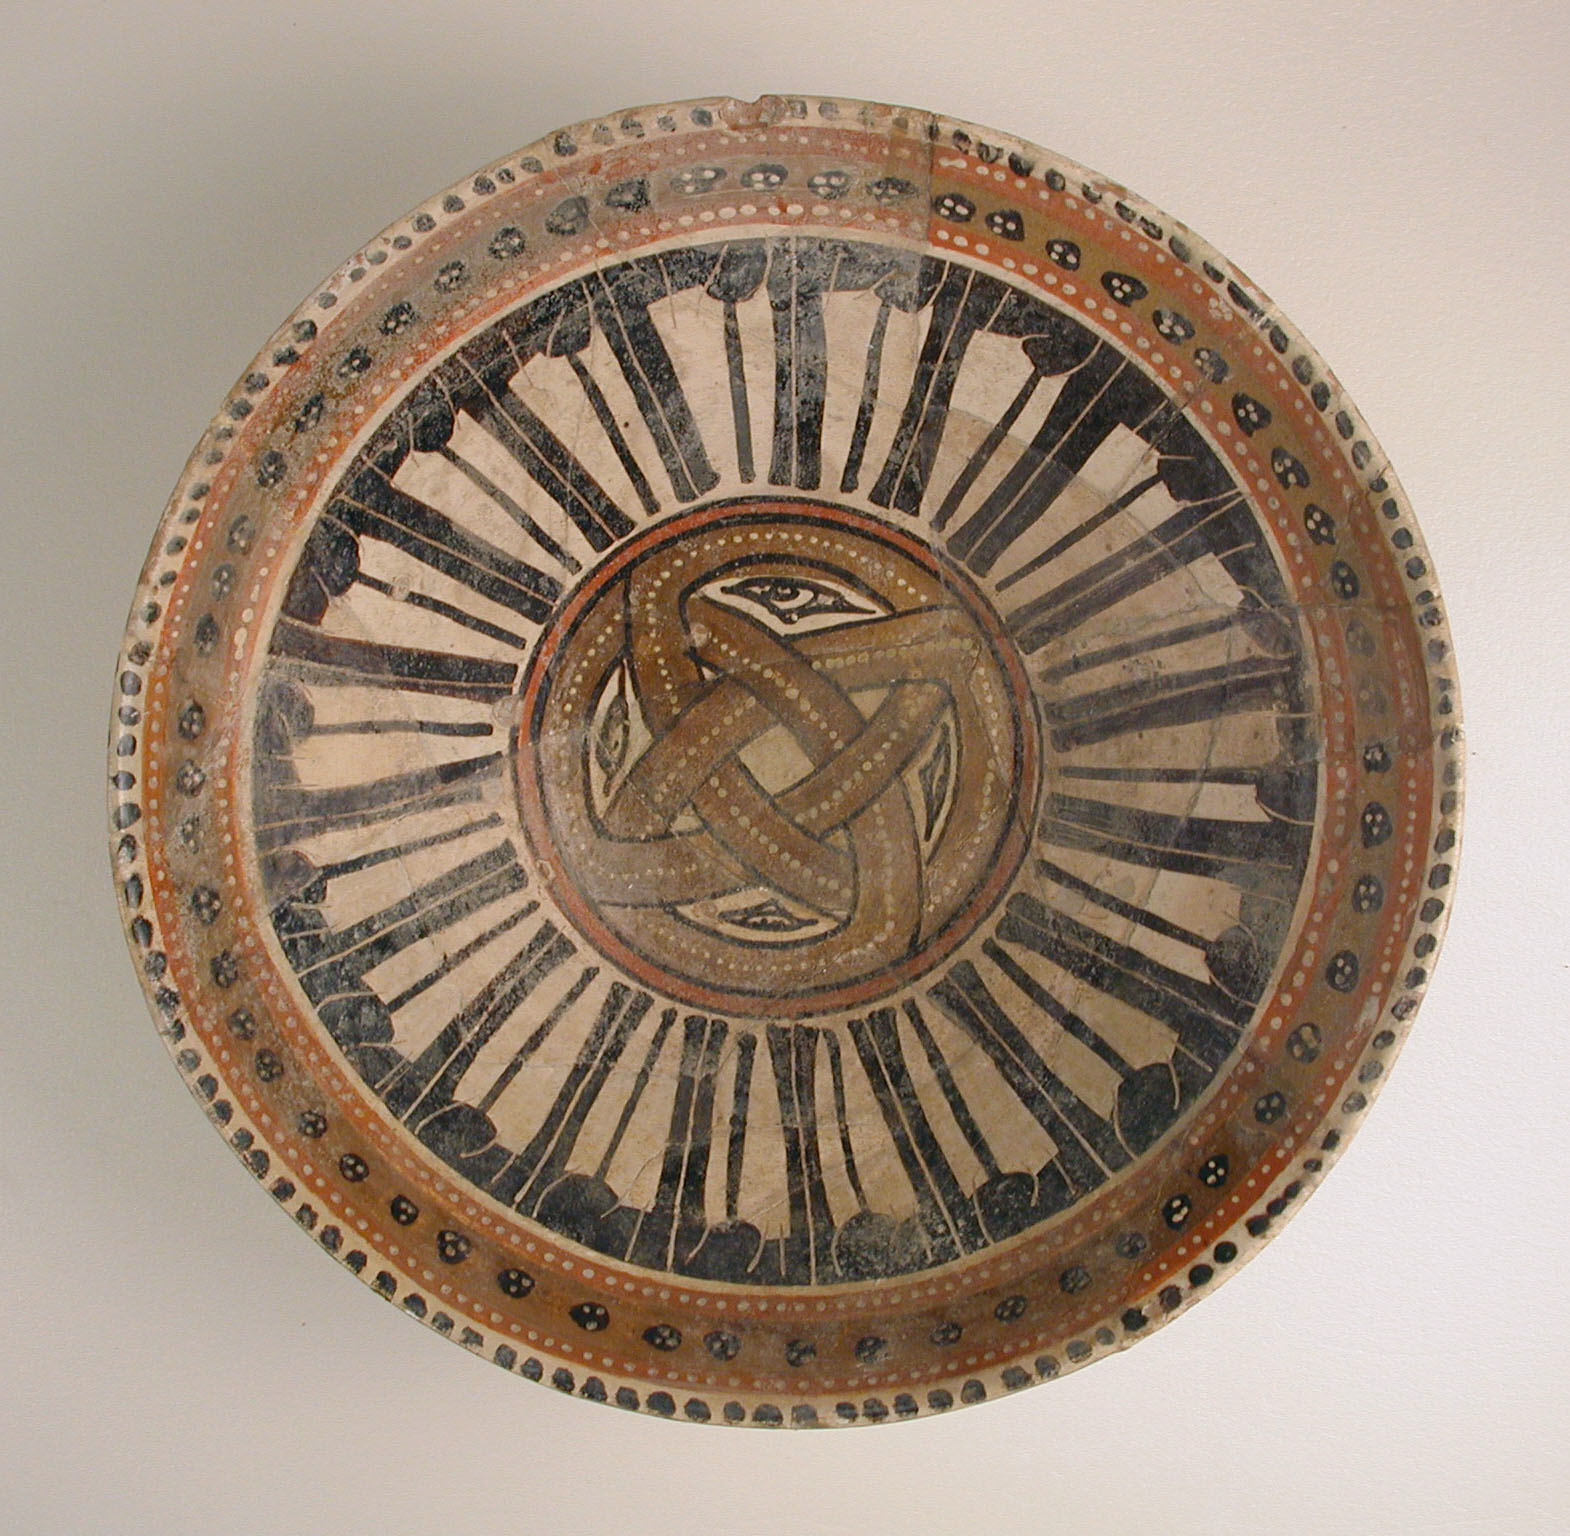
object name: bowl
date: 801-1000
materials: earthenware, glaze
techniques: polychrome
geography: uzbekistan